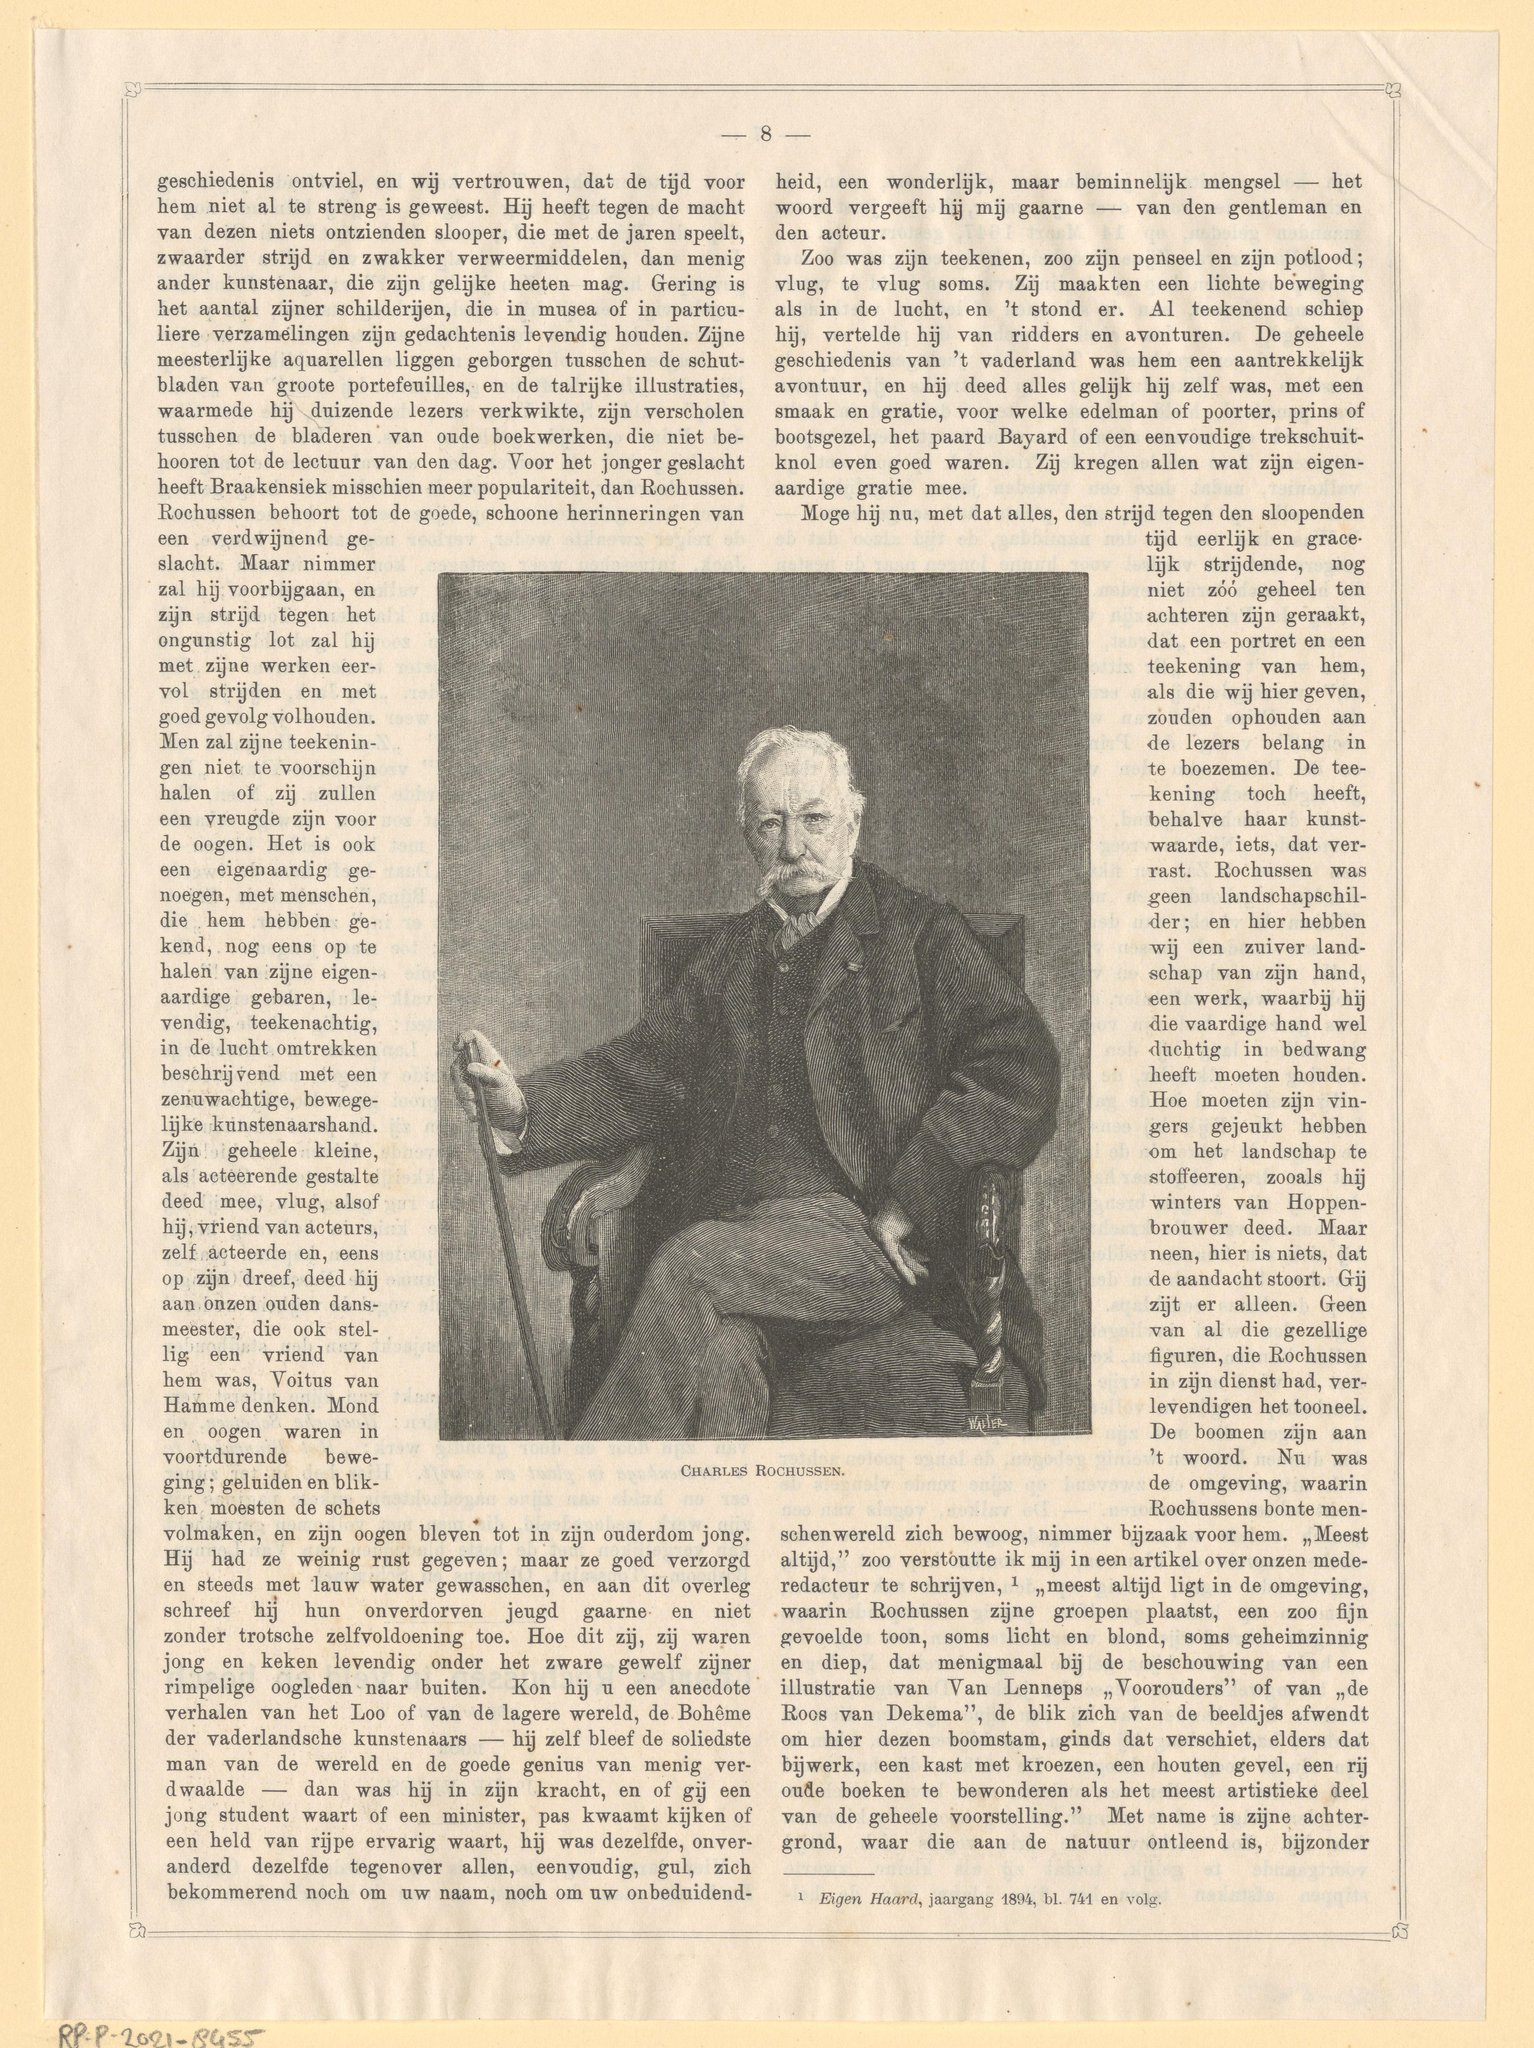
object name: print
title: Portret van Charles Rochussen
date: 1899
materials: paper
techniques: letterpress printing, engraving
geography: haarlem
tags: rotterdam, painter, print maker, draughtsman, charles rochussen, historical persons